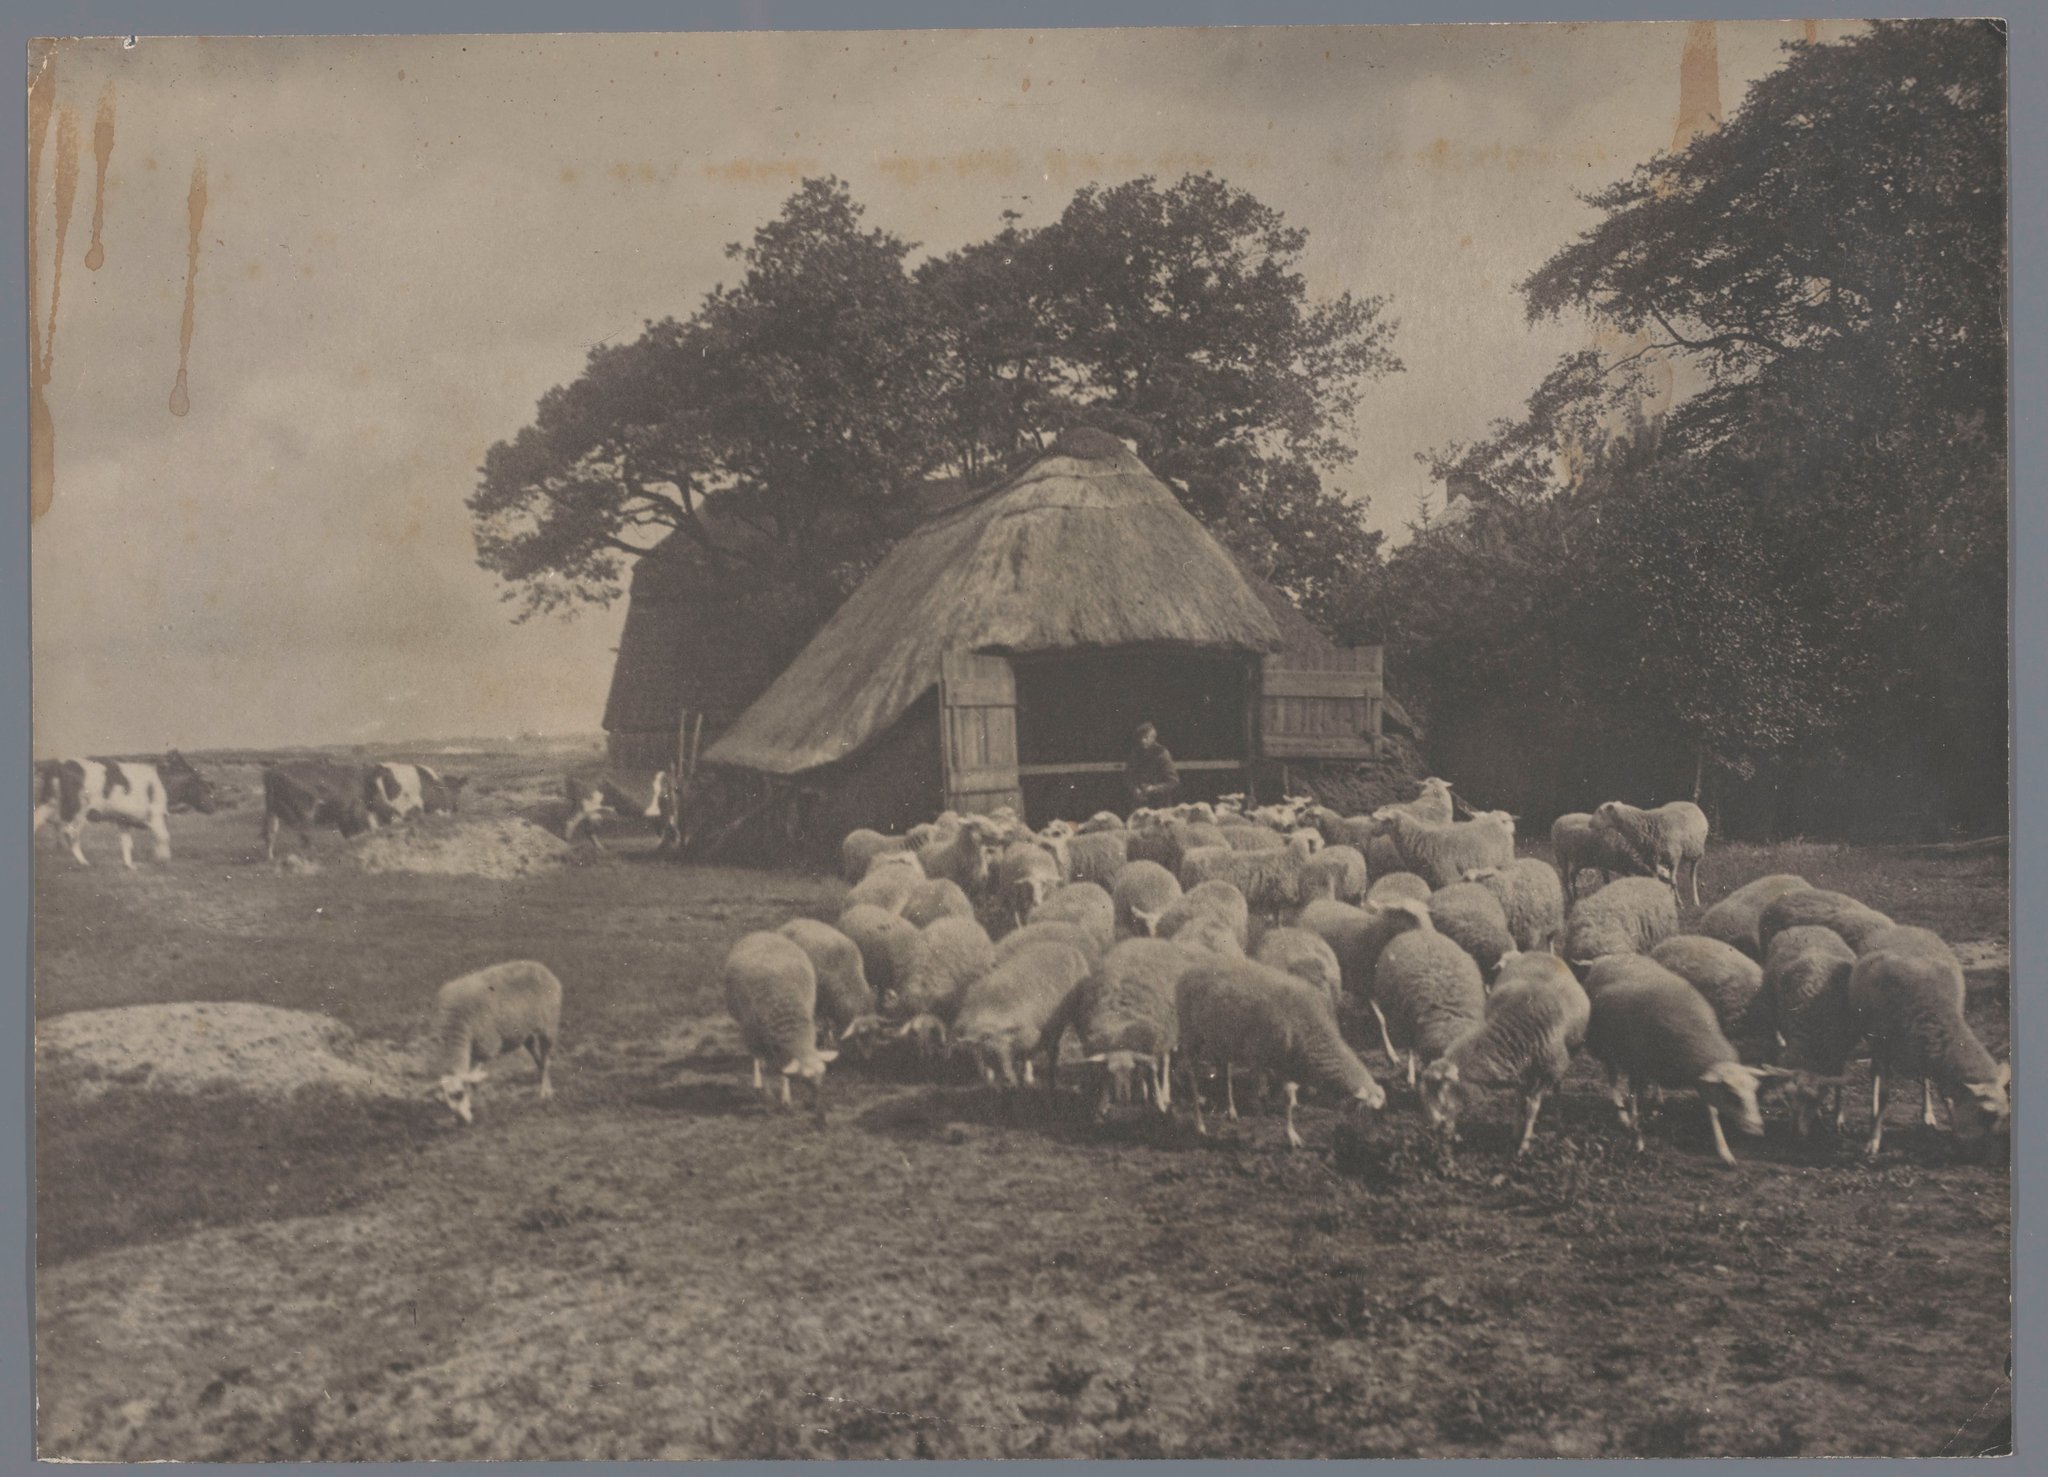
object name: photograph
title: De Schaapskooi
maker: alb. kapteijn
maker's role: amateurfotograaf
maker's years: 1848-1927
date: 1900-1925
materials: cardboard, paper, photographic support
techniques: carbon print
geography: netherlands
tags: sheep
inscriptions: annotation: ‘9 à 10 T / [...] 10 à 11’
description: Landschap met schapen, koeien, boer en schaapskooi, Nederland